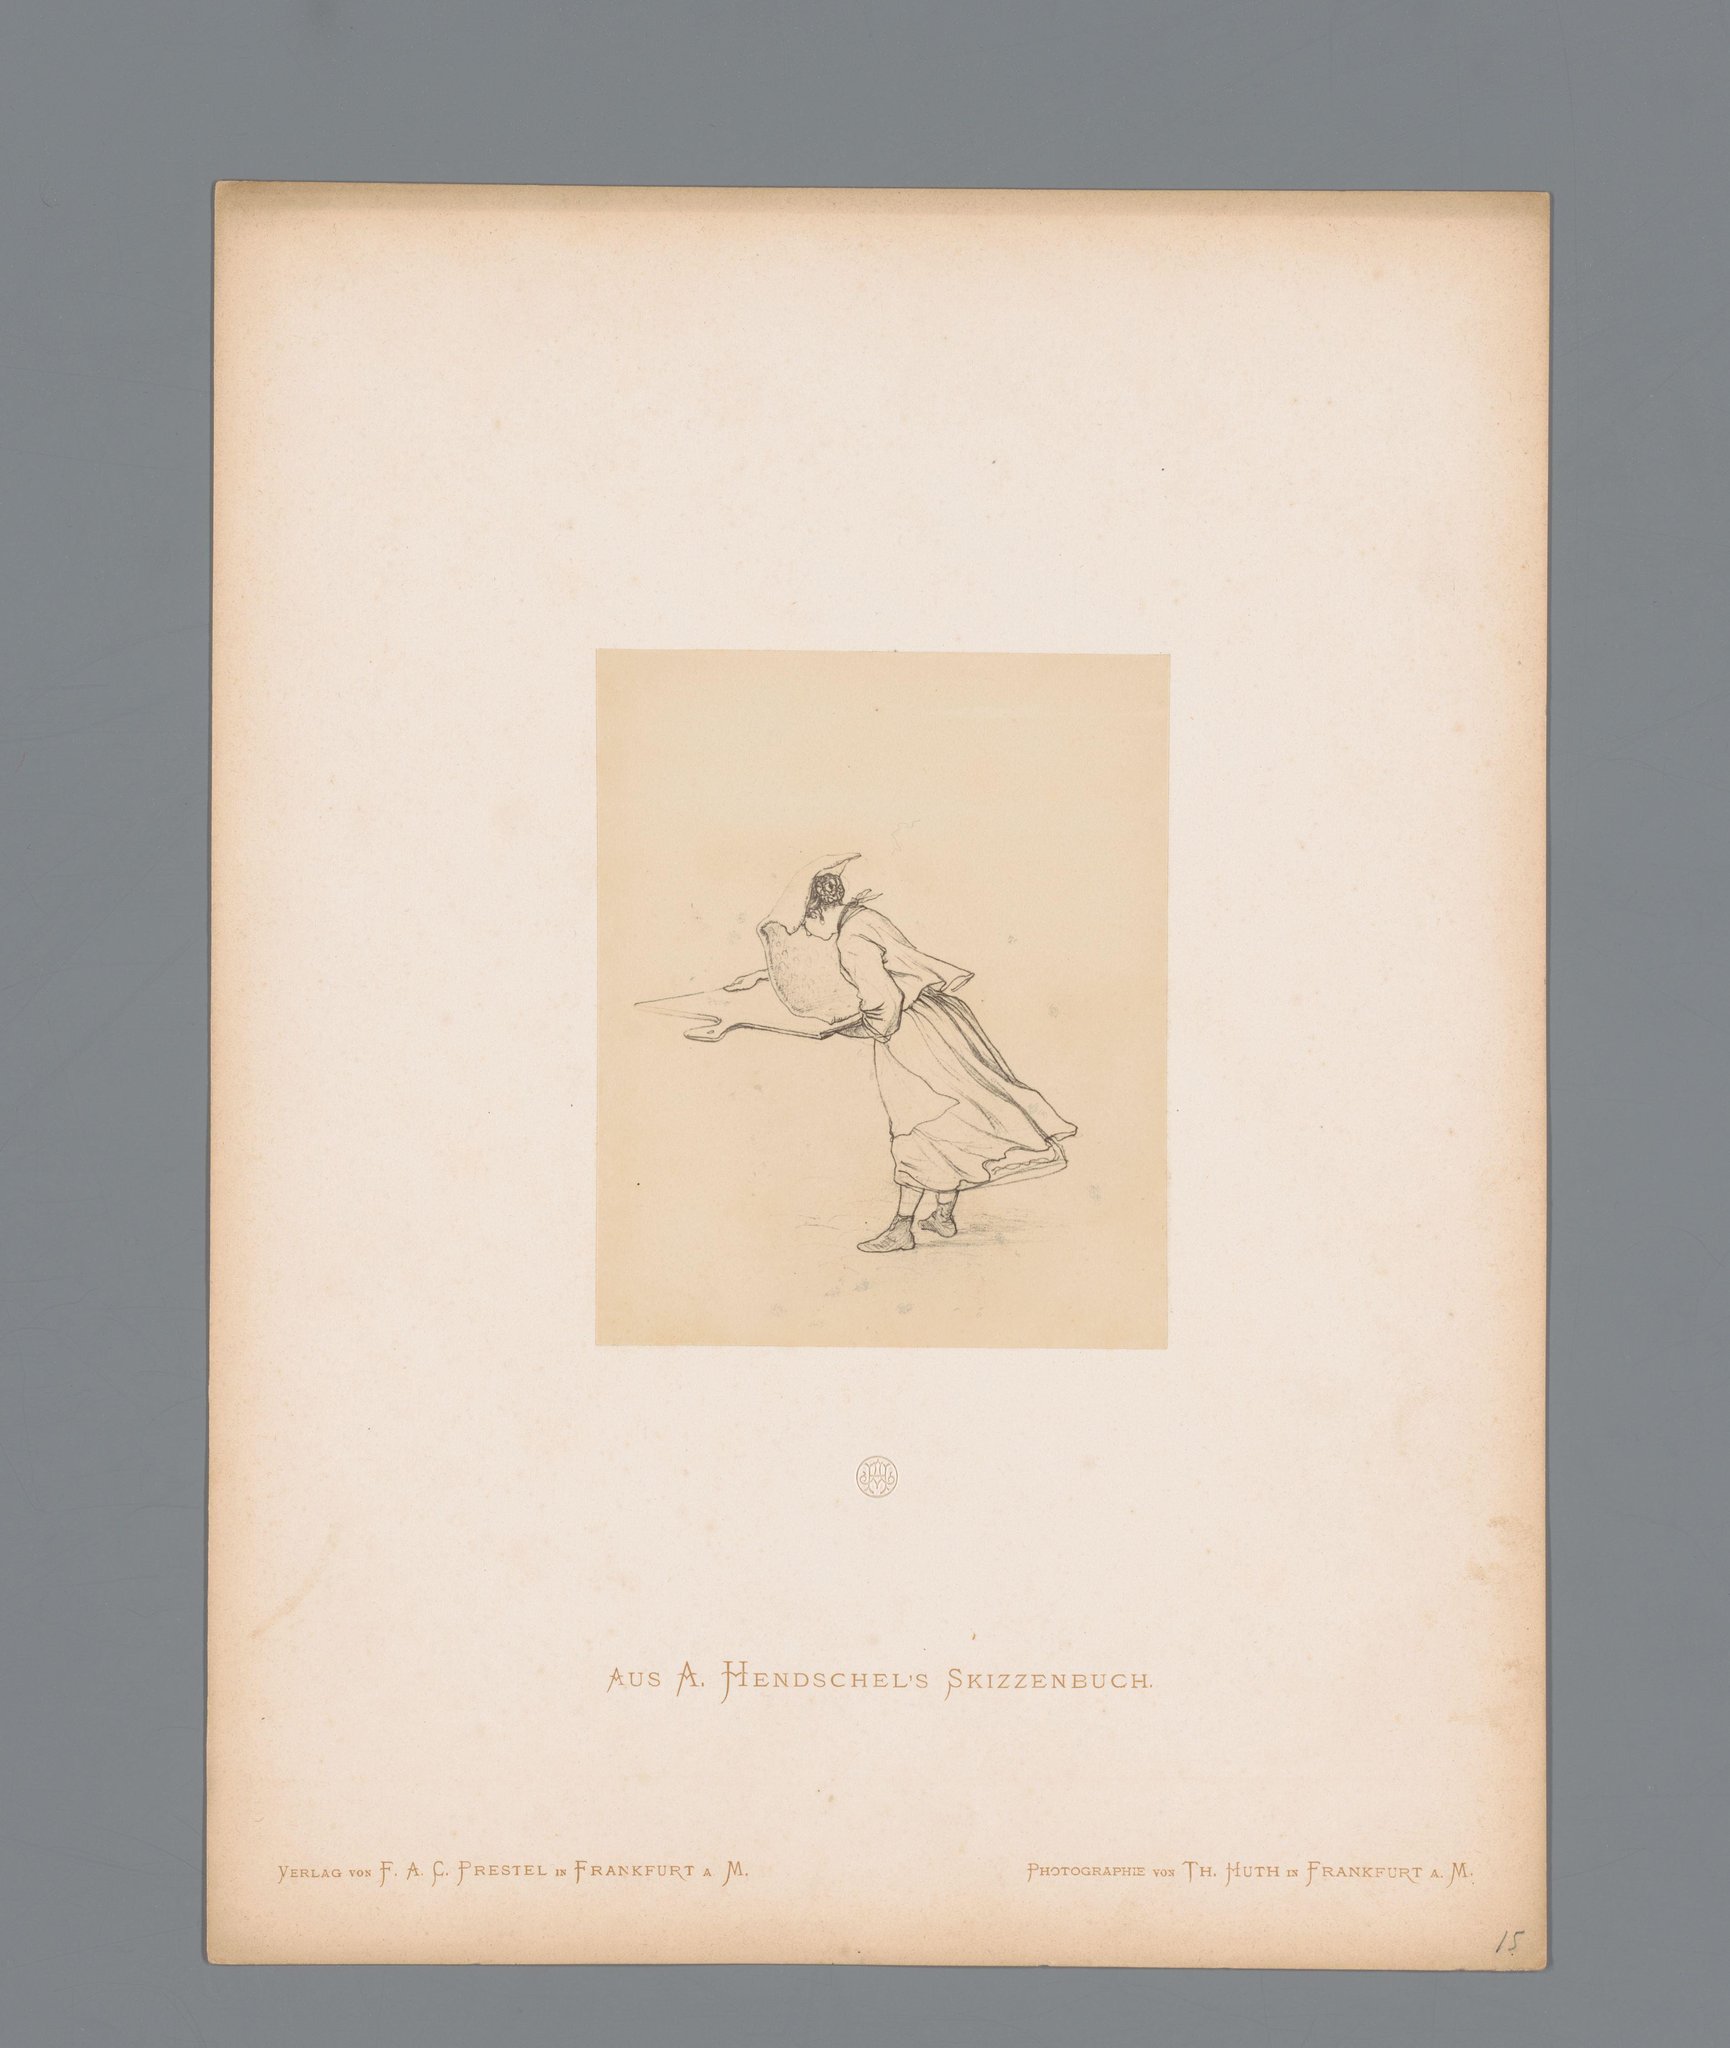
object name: photograph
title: Fotoreproductie van een schets van een dienstmeid in een storm door Albert Hendschel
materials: photographic support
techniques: albumen print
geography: frankfurt am main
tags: storm, kitchen-maid, kitchen servant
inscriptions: number: ‘15’, monogram: ‘AH’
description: Deze foto maakt deel uit van een omslag met 50 foto's op 48 bladen, een lijst van afbeeldingen en een titelblad.